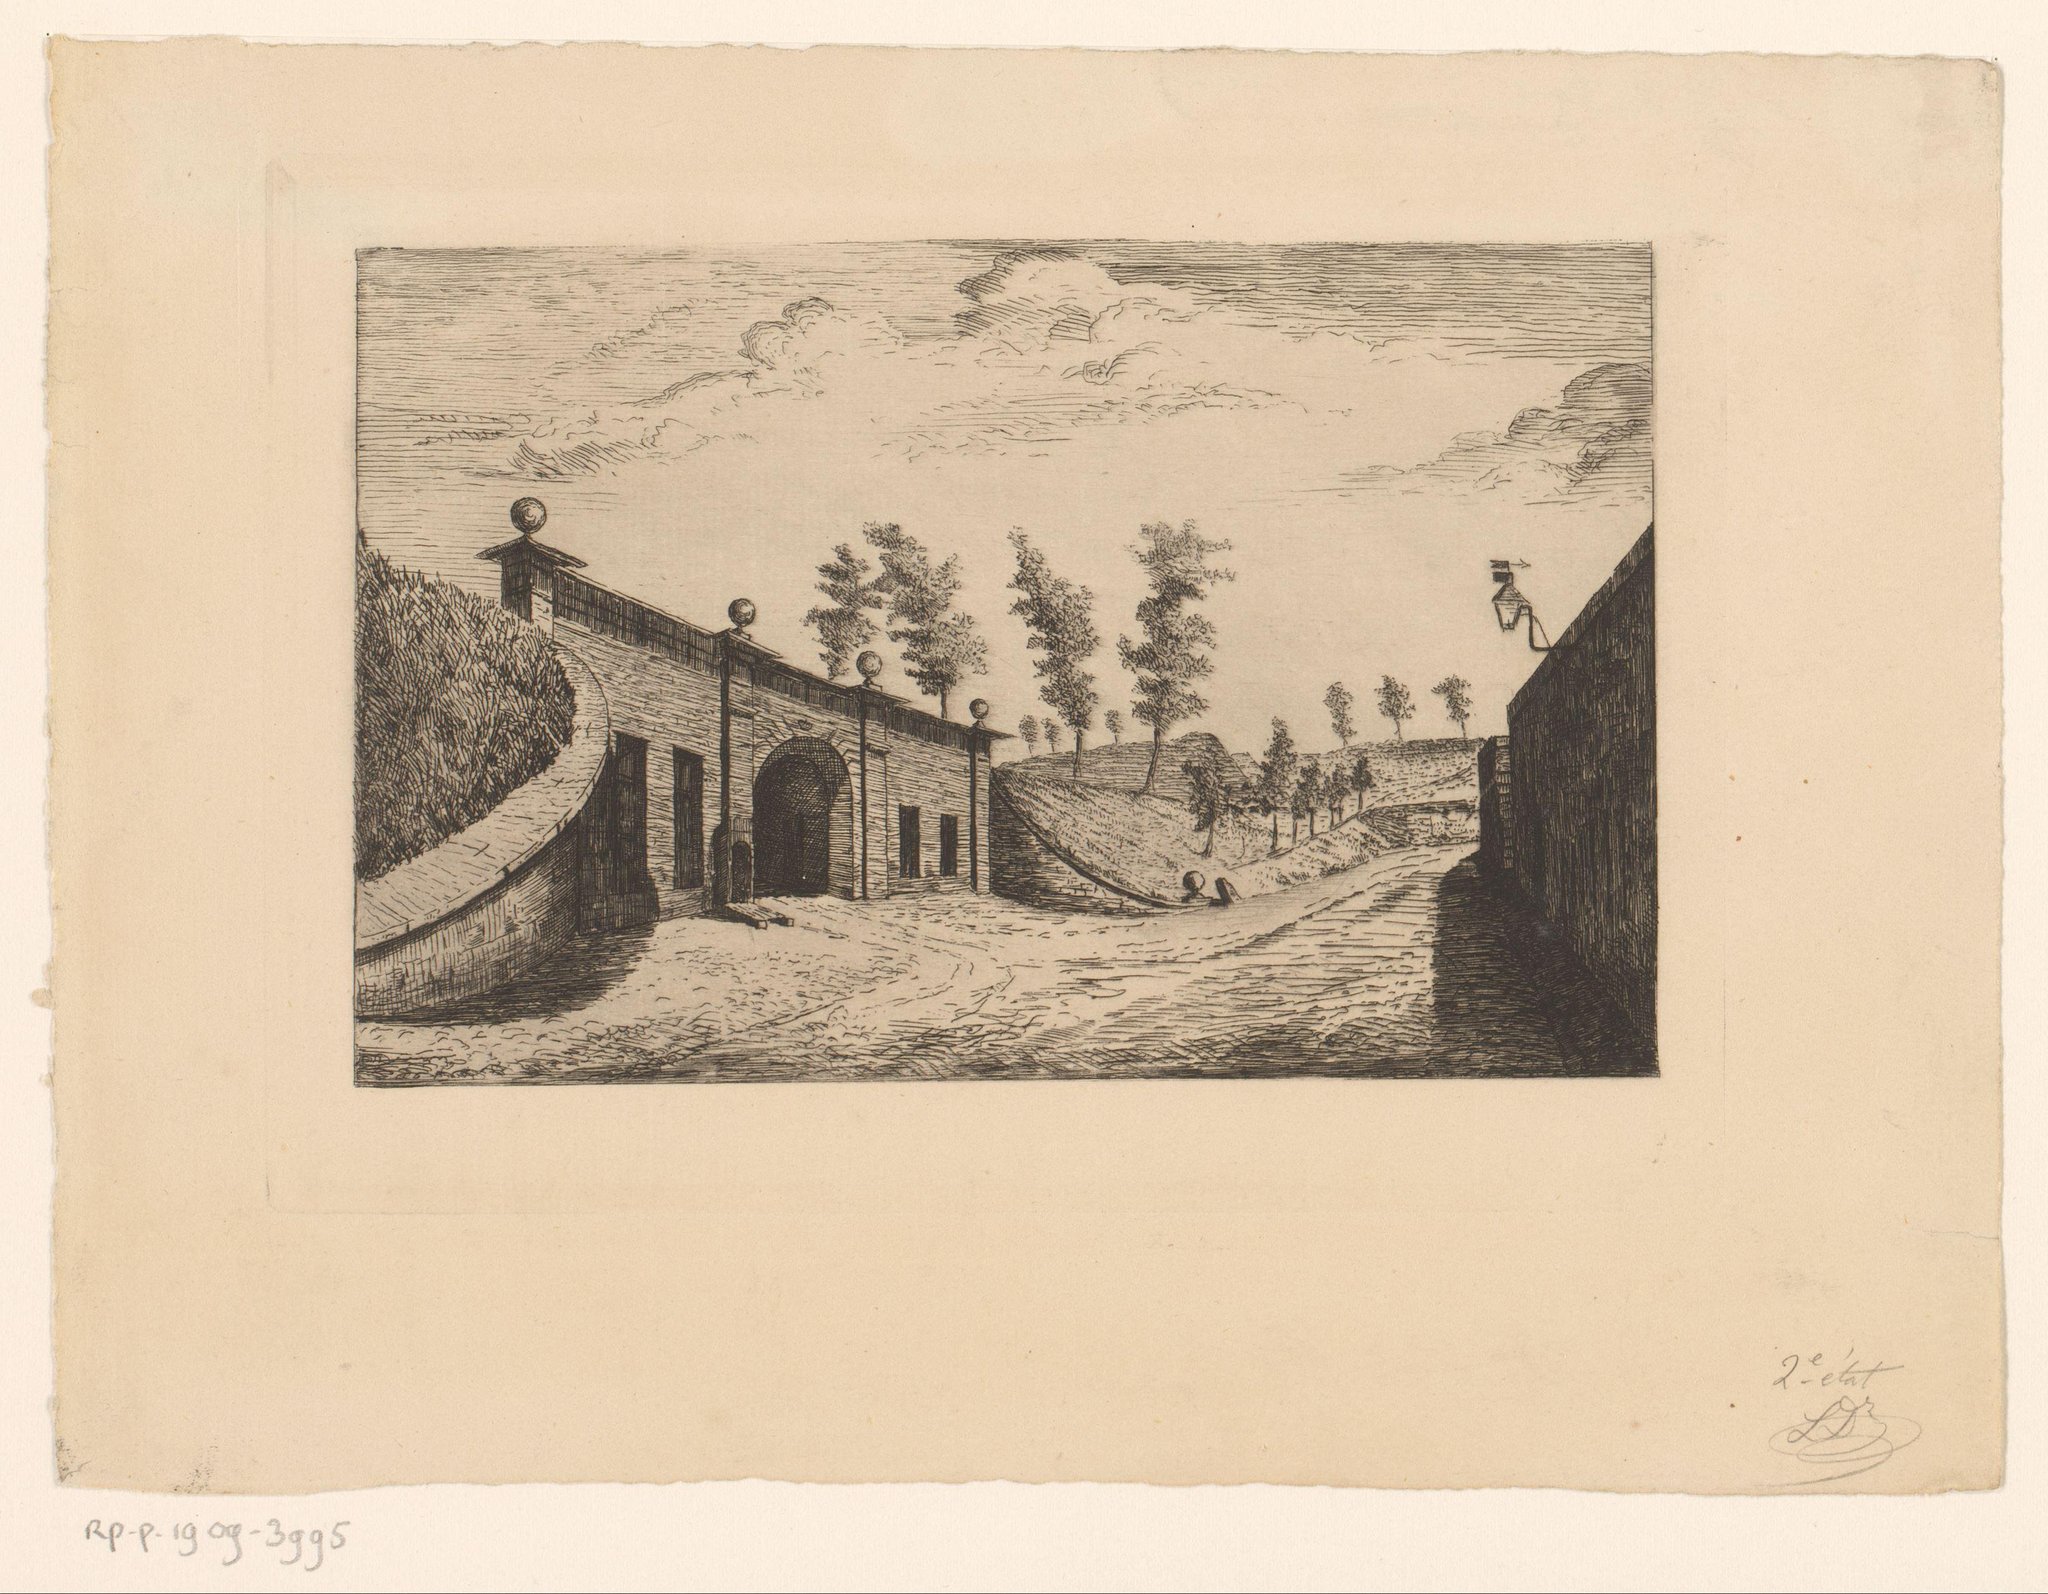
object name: print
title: Fortifications de Mons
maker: léon dolez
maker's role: print maker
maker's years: 1837-1902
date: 1875-1878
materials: paper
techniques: drypoint, etching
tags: city-gate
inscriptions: collector's mark: Lugt 2228